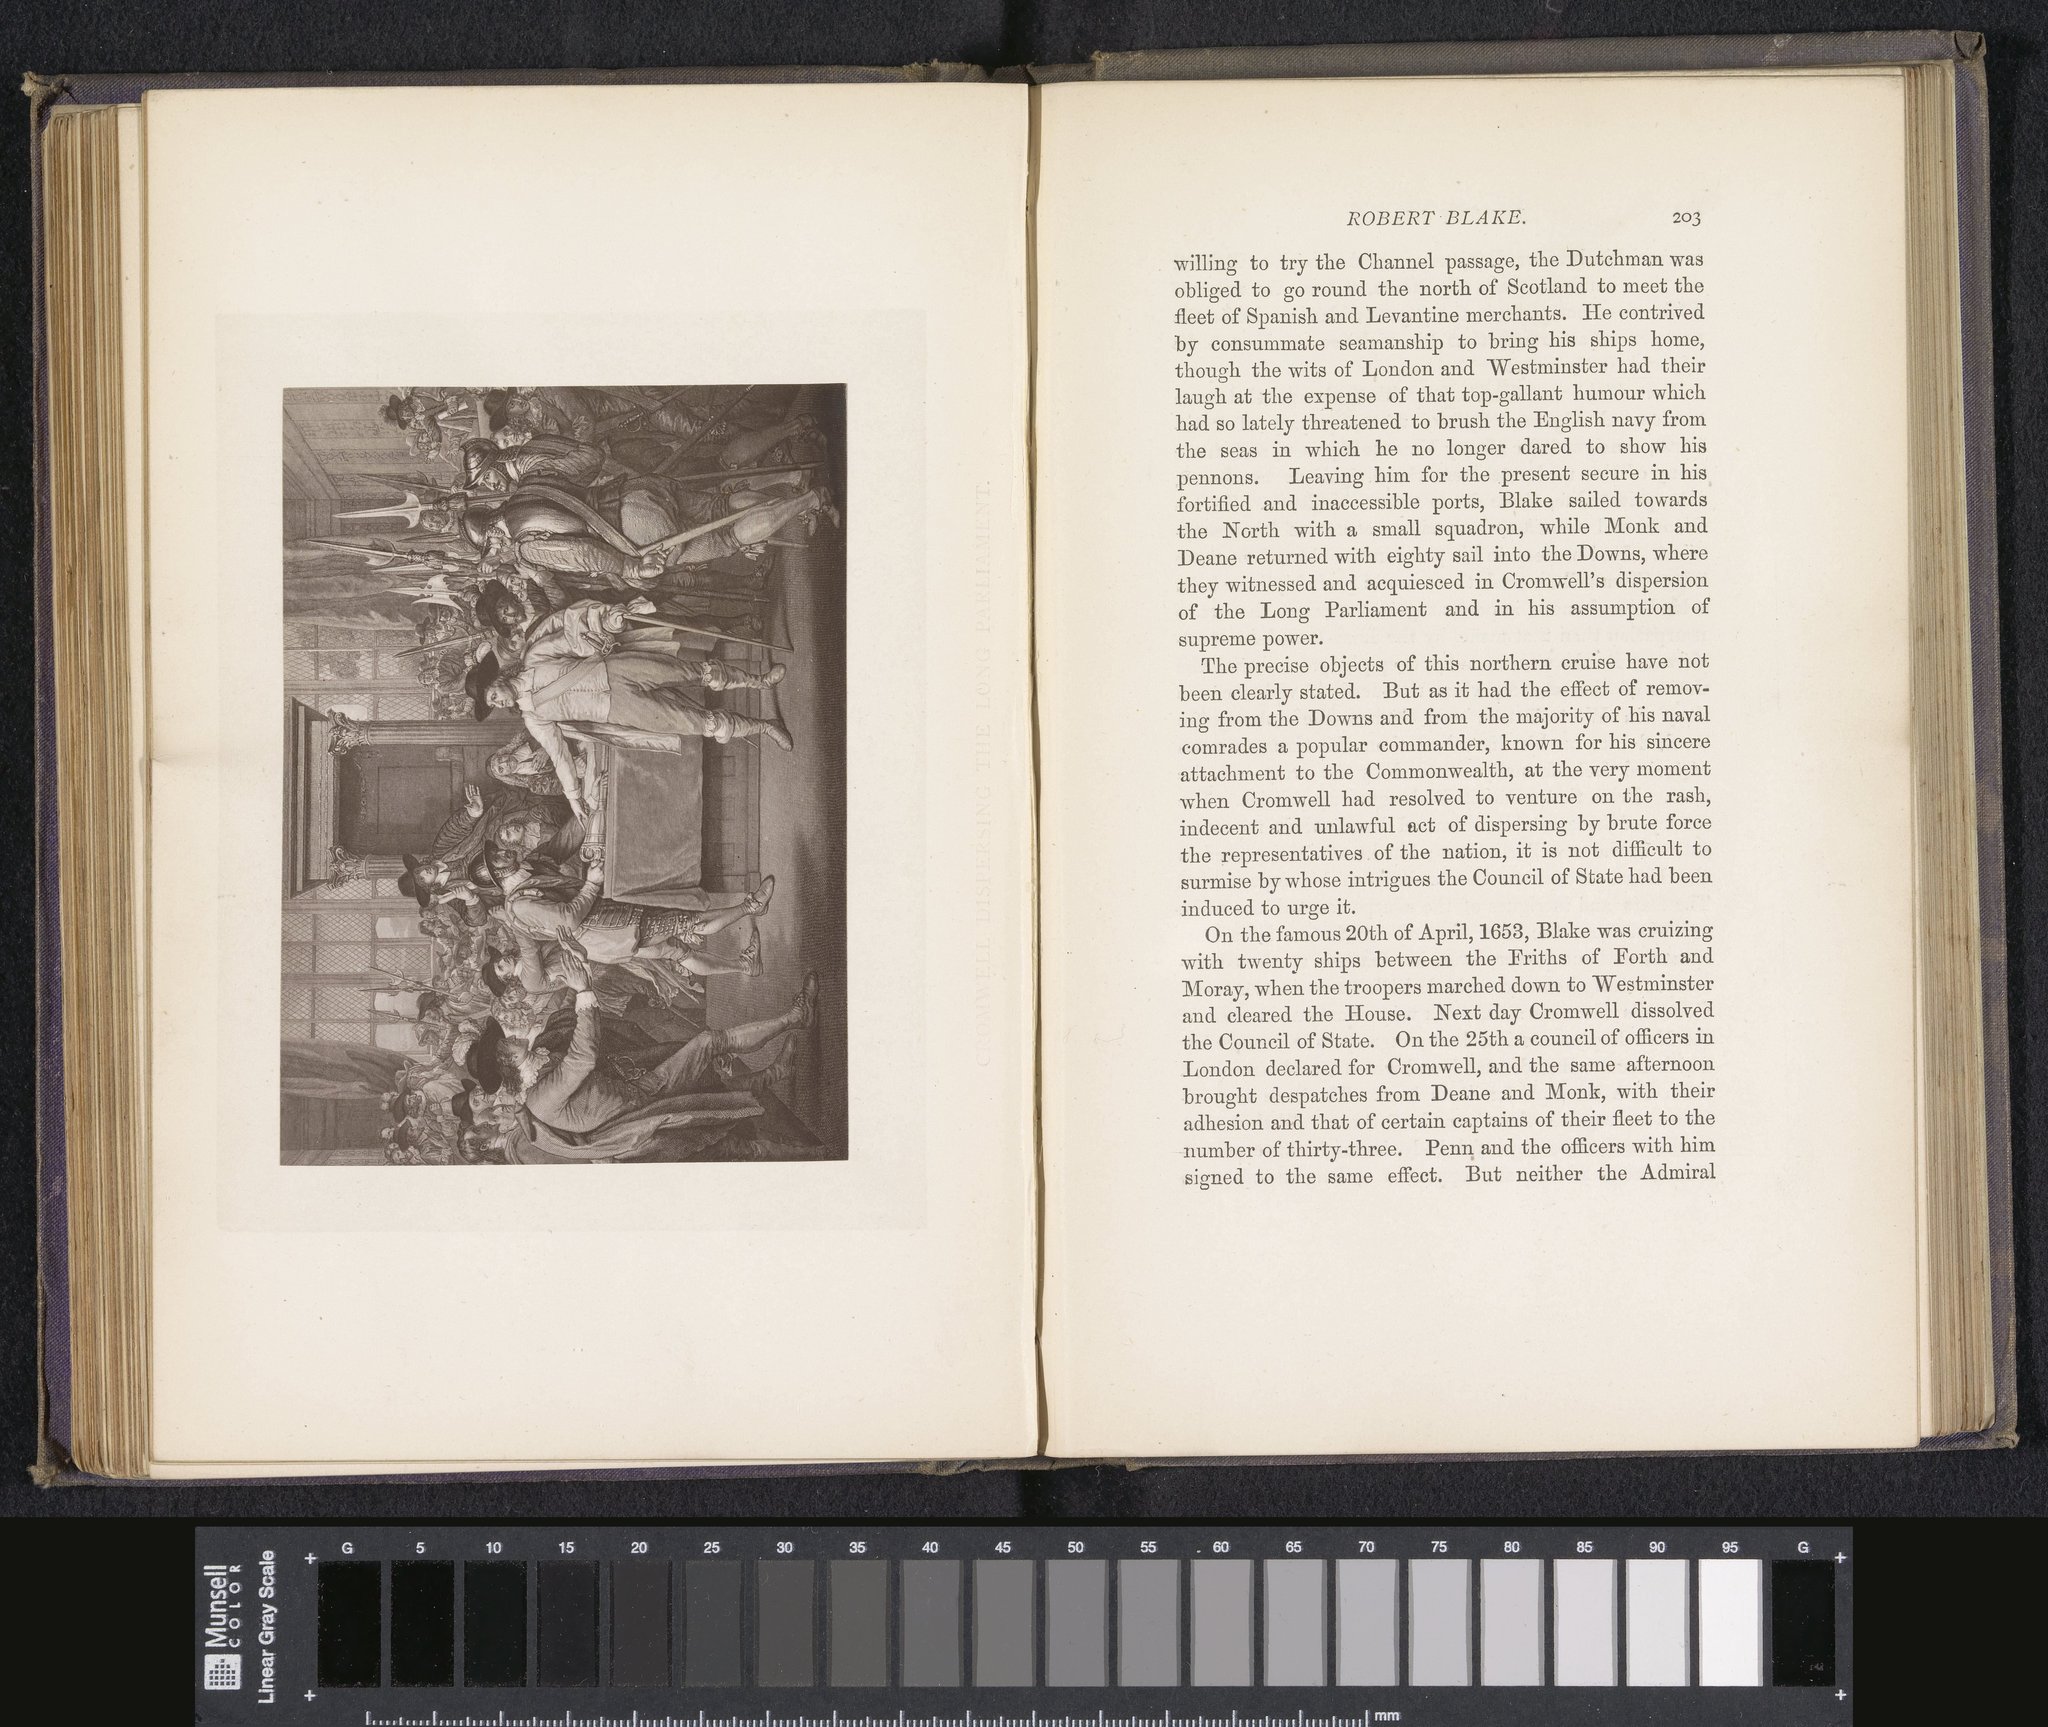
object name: photomechanical print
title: Cromwell dispersing the long parliament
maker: Anonymous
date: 1875-1885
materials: paper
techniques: woodburytype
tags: london, oliver cromwell, debate, discussion (~ parliament)